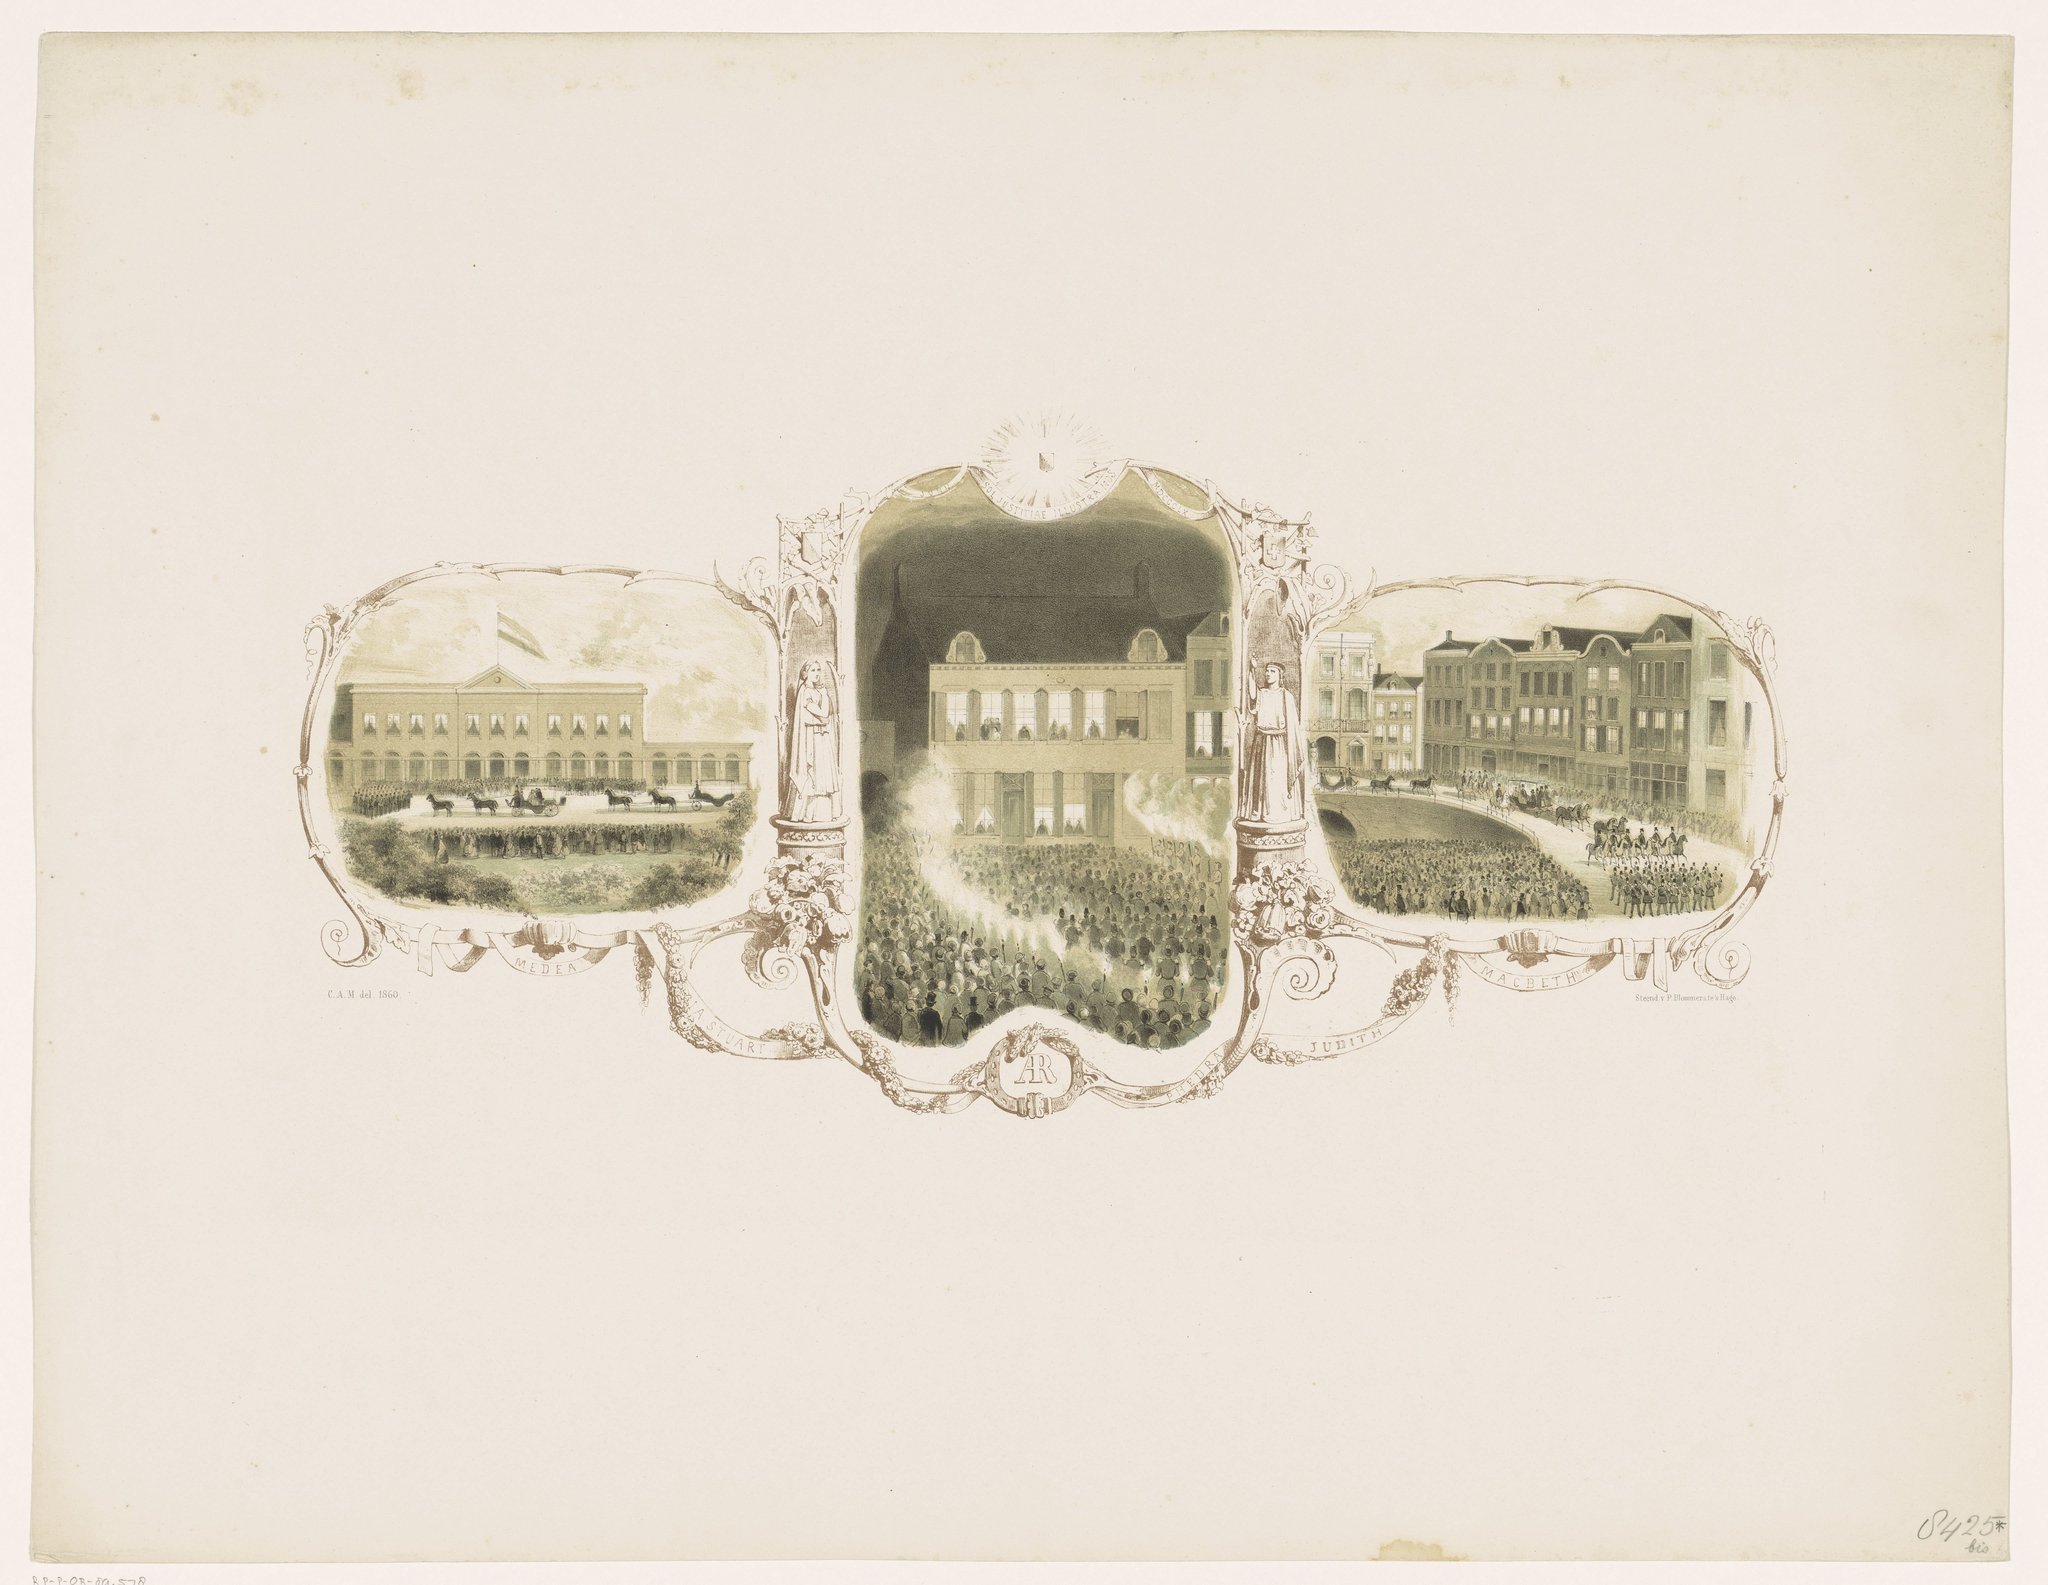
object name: print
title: Inhalen en uitleiden van de actrice Adelaide Ristori door de Utrechtse studenten, 1860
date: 1861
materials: paper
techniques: lithograph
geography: the hague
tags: arrival and return ~ travelling, student life, serenade to the beloved, utrecht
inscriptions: collector's mark: Lugt 2228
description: Drie scènes van het inhalen te Utrecht van de Italiaanse tragédienne (Marchese) Adelaide Ristori, de serenade haar gebracht in juni 1860 en het uitleiden door de Utrechtse studenten. Blad uit het Utrechtse studentenalmanak van 1861.